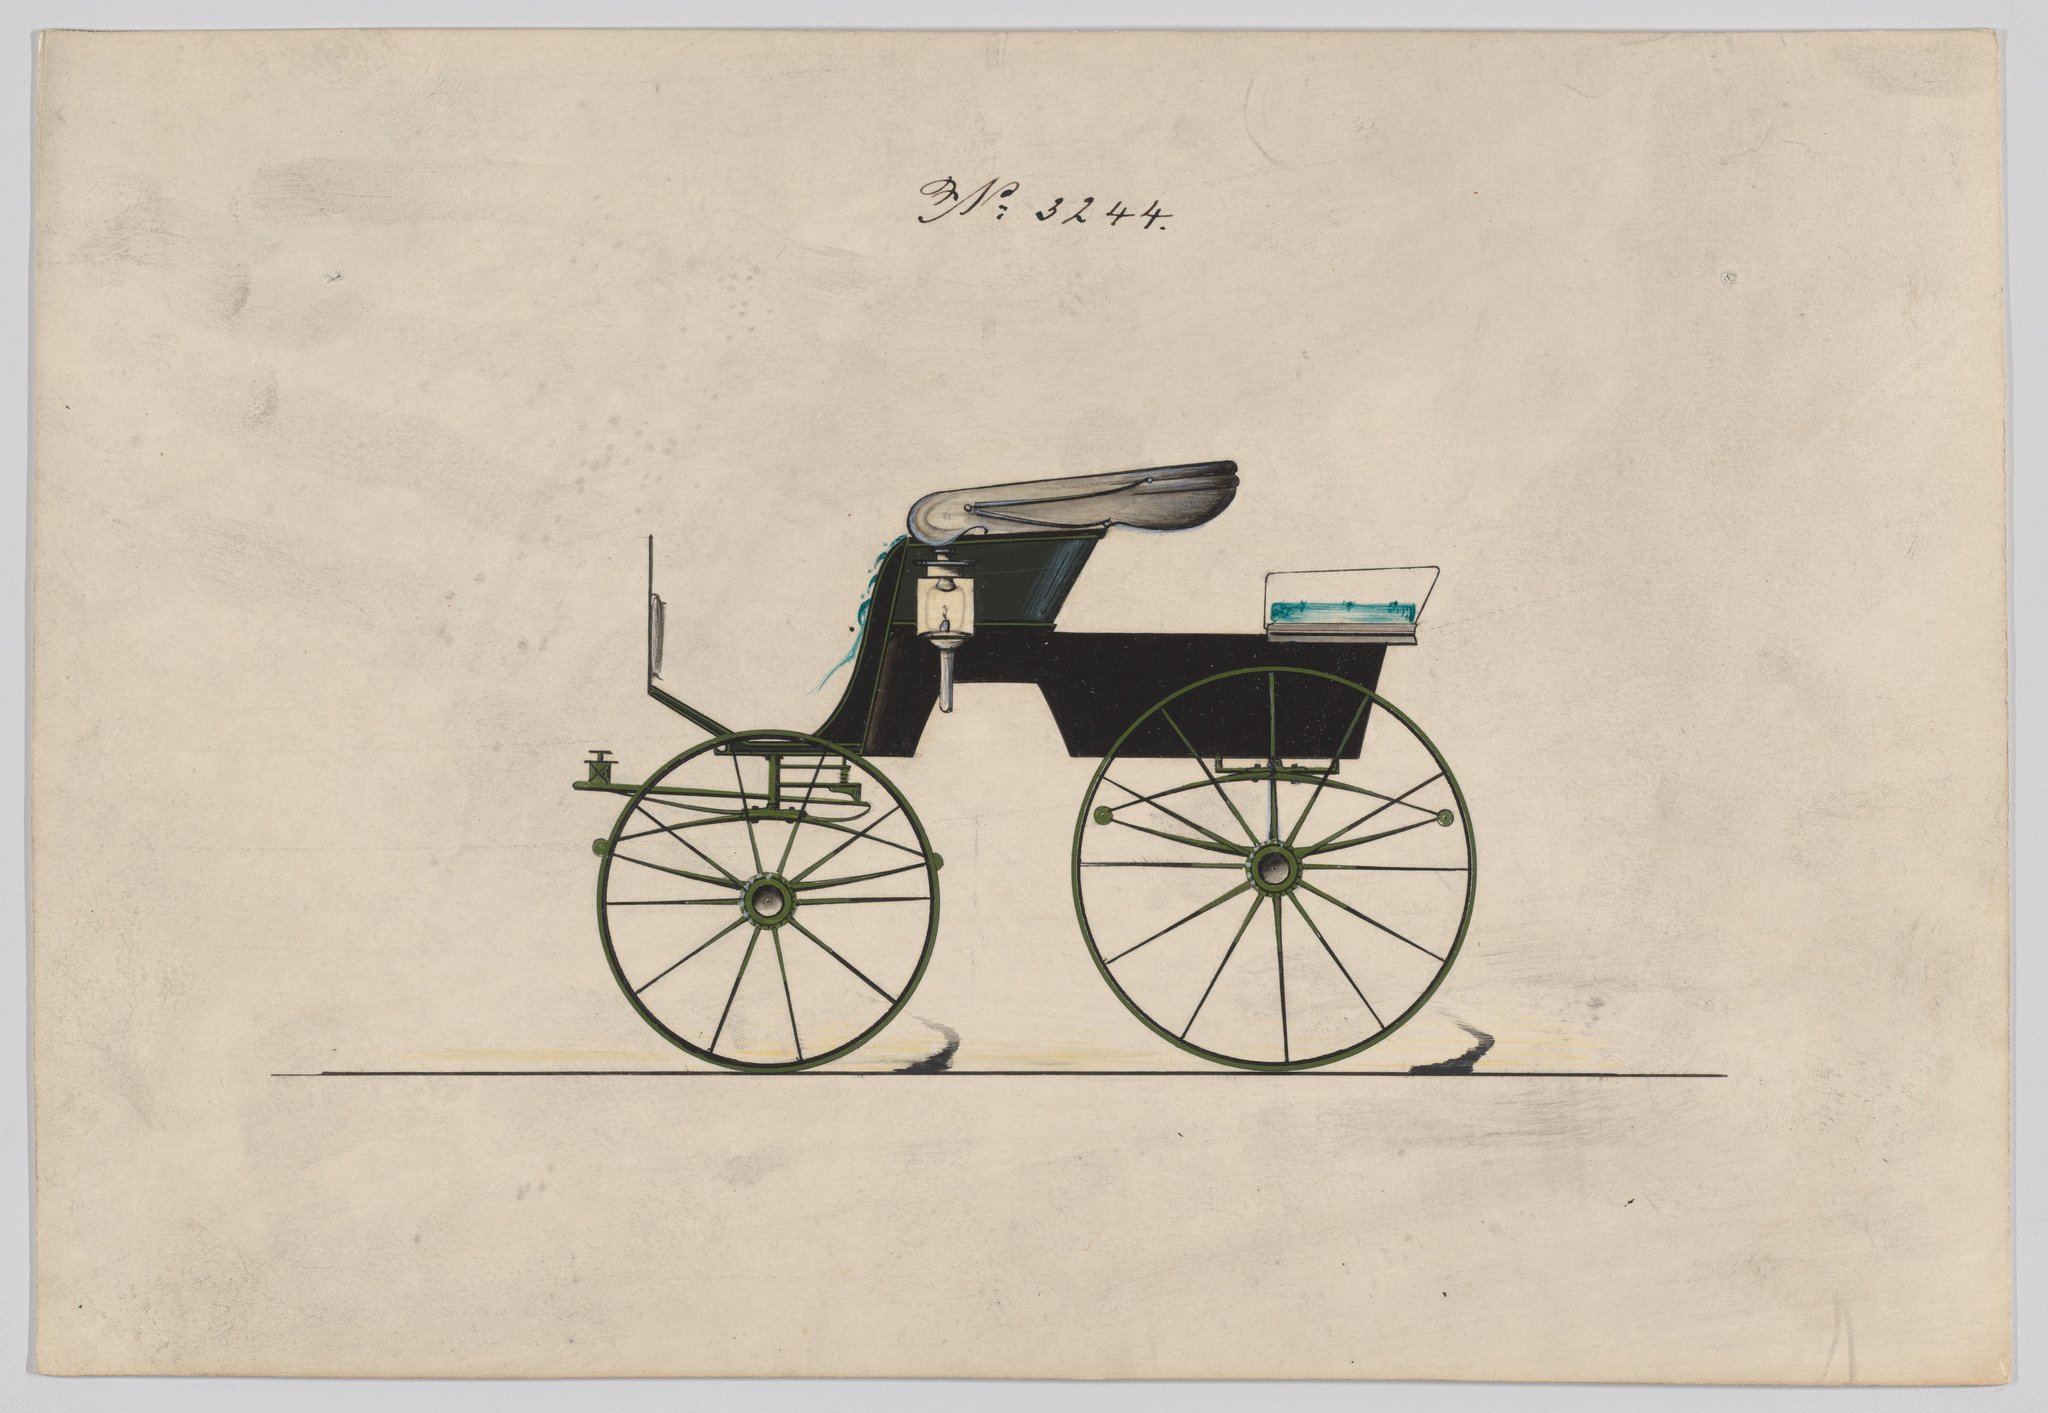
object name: drawing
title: Design for Stanhope Phaeton, no. 3244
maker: brewster & co.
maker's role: manufacturer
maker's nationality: american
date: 1876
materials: gouache, gum arabic, ink, watercolor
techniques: pen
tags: carriages